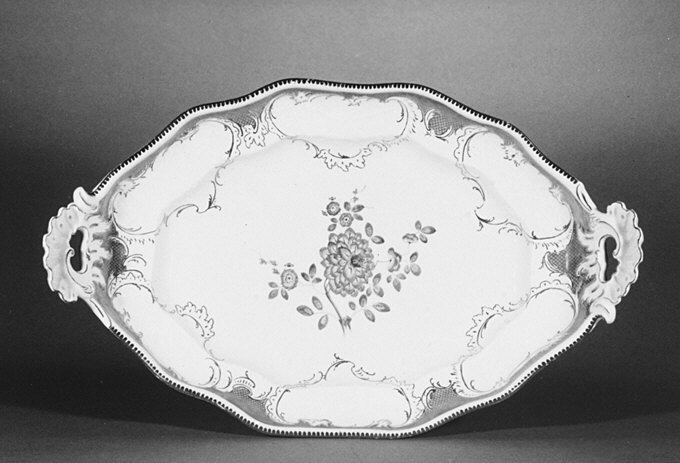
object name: stand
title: Stand (part of a service)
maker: meissen manufactory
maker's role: manufactory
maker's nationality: german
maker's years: 1710-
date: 1761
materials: hard paste porcelain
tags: flowers